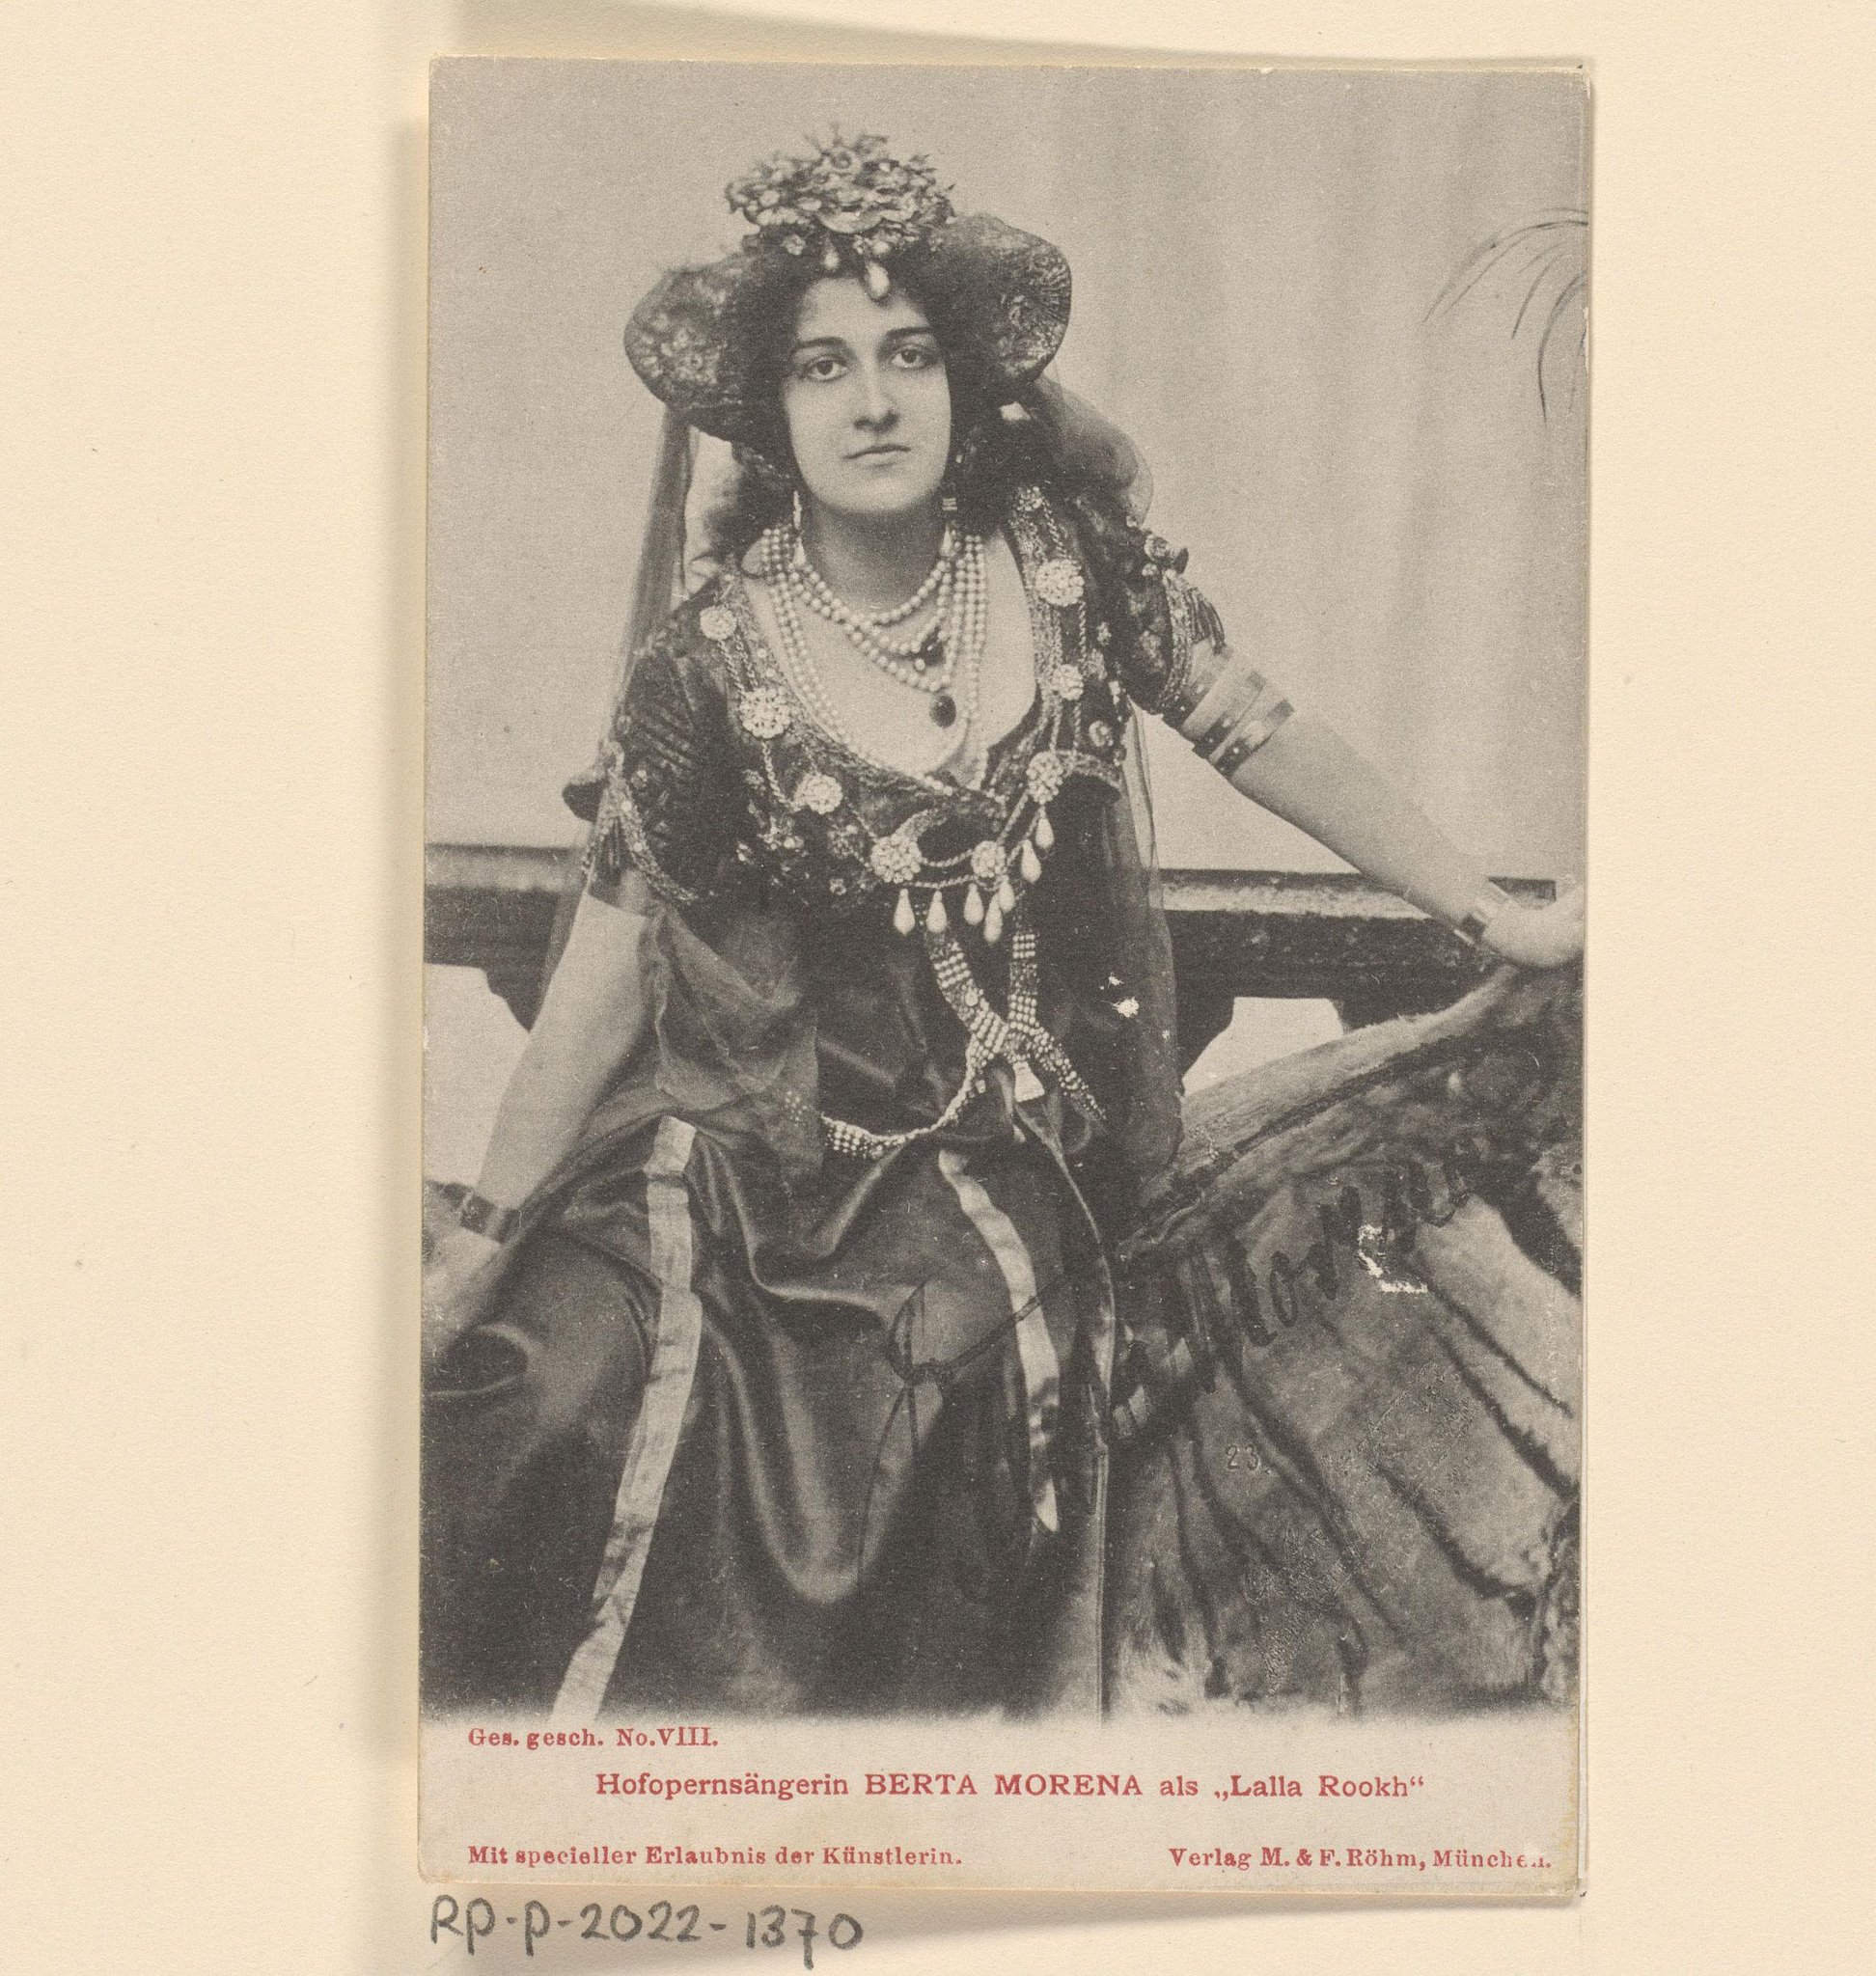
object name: photomechanical print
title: Hofopernsängerin Berta Morena als "Lalla Rookh"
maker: Anonymous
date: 1892-1905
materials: paper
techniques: photograph, letterpress printing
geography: munich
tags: historical persons - bb - woman, opera-singer (female)